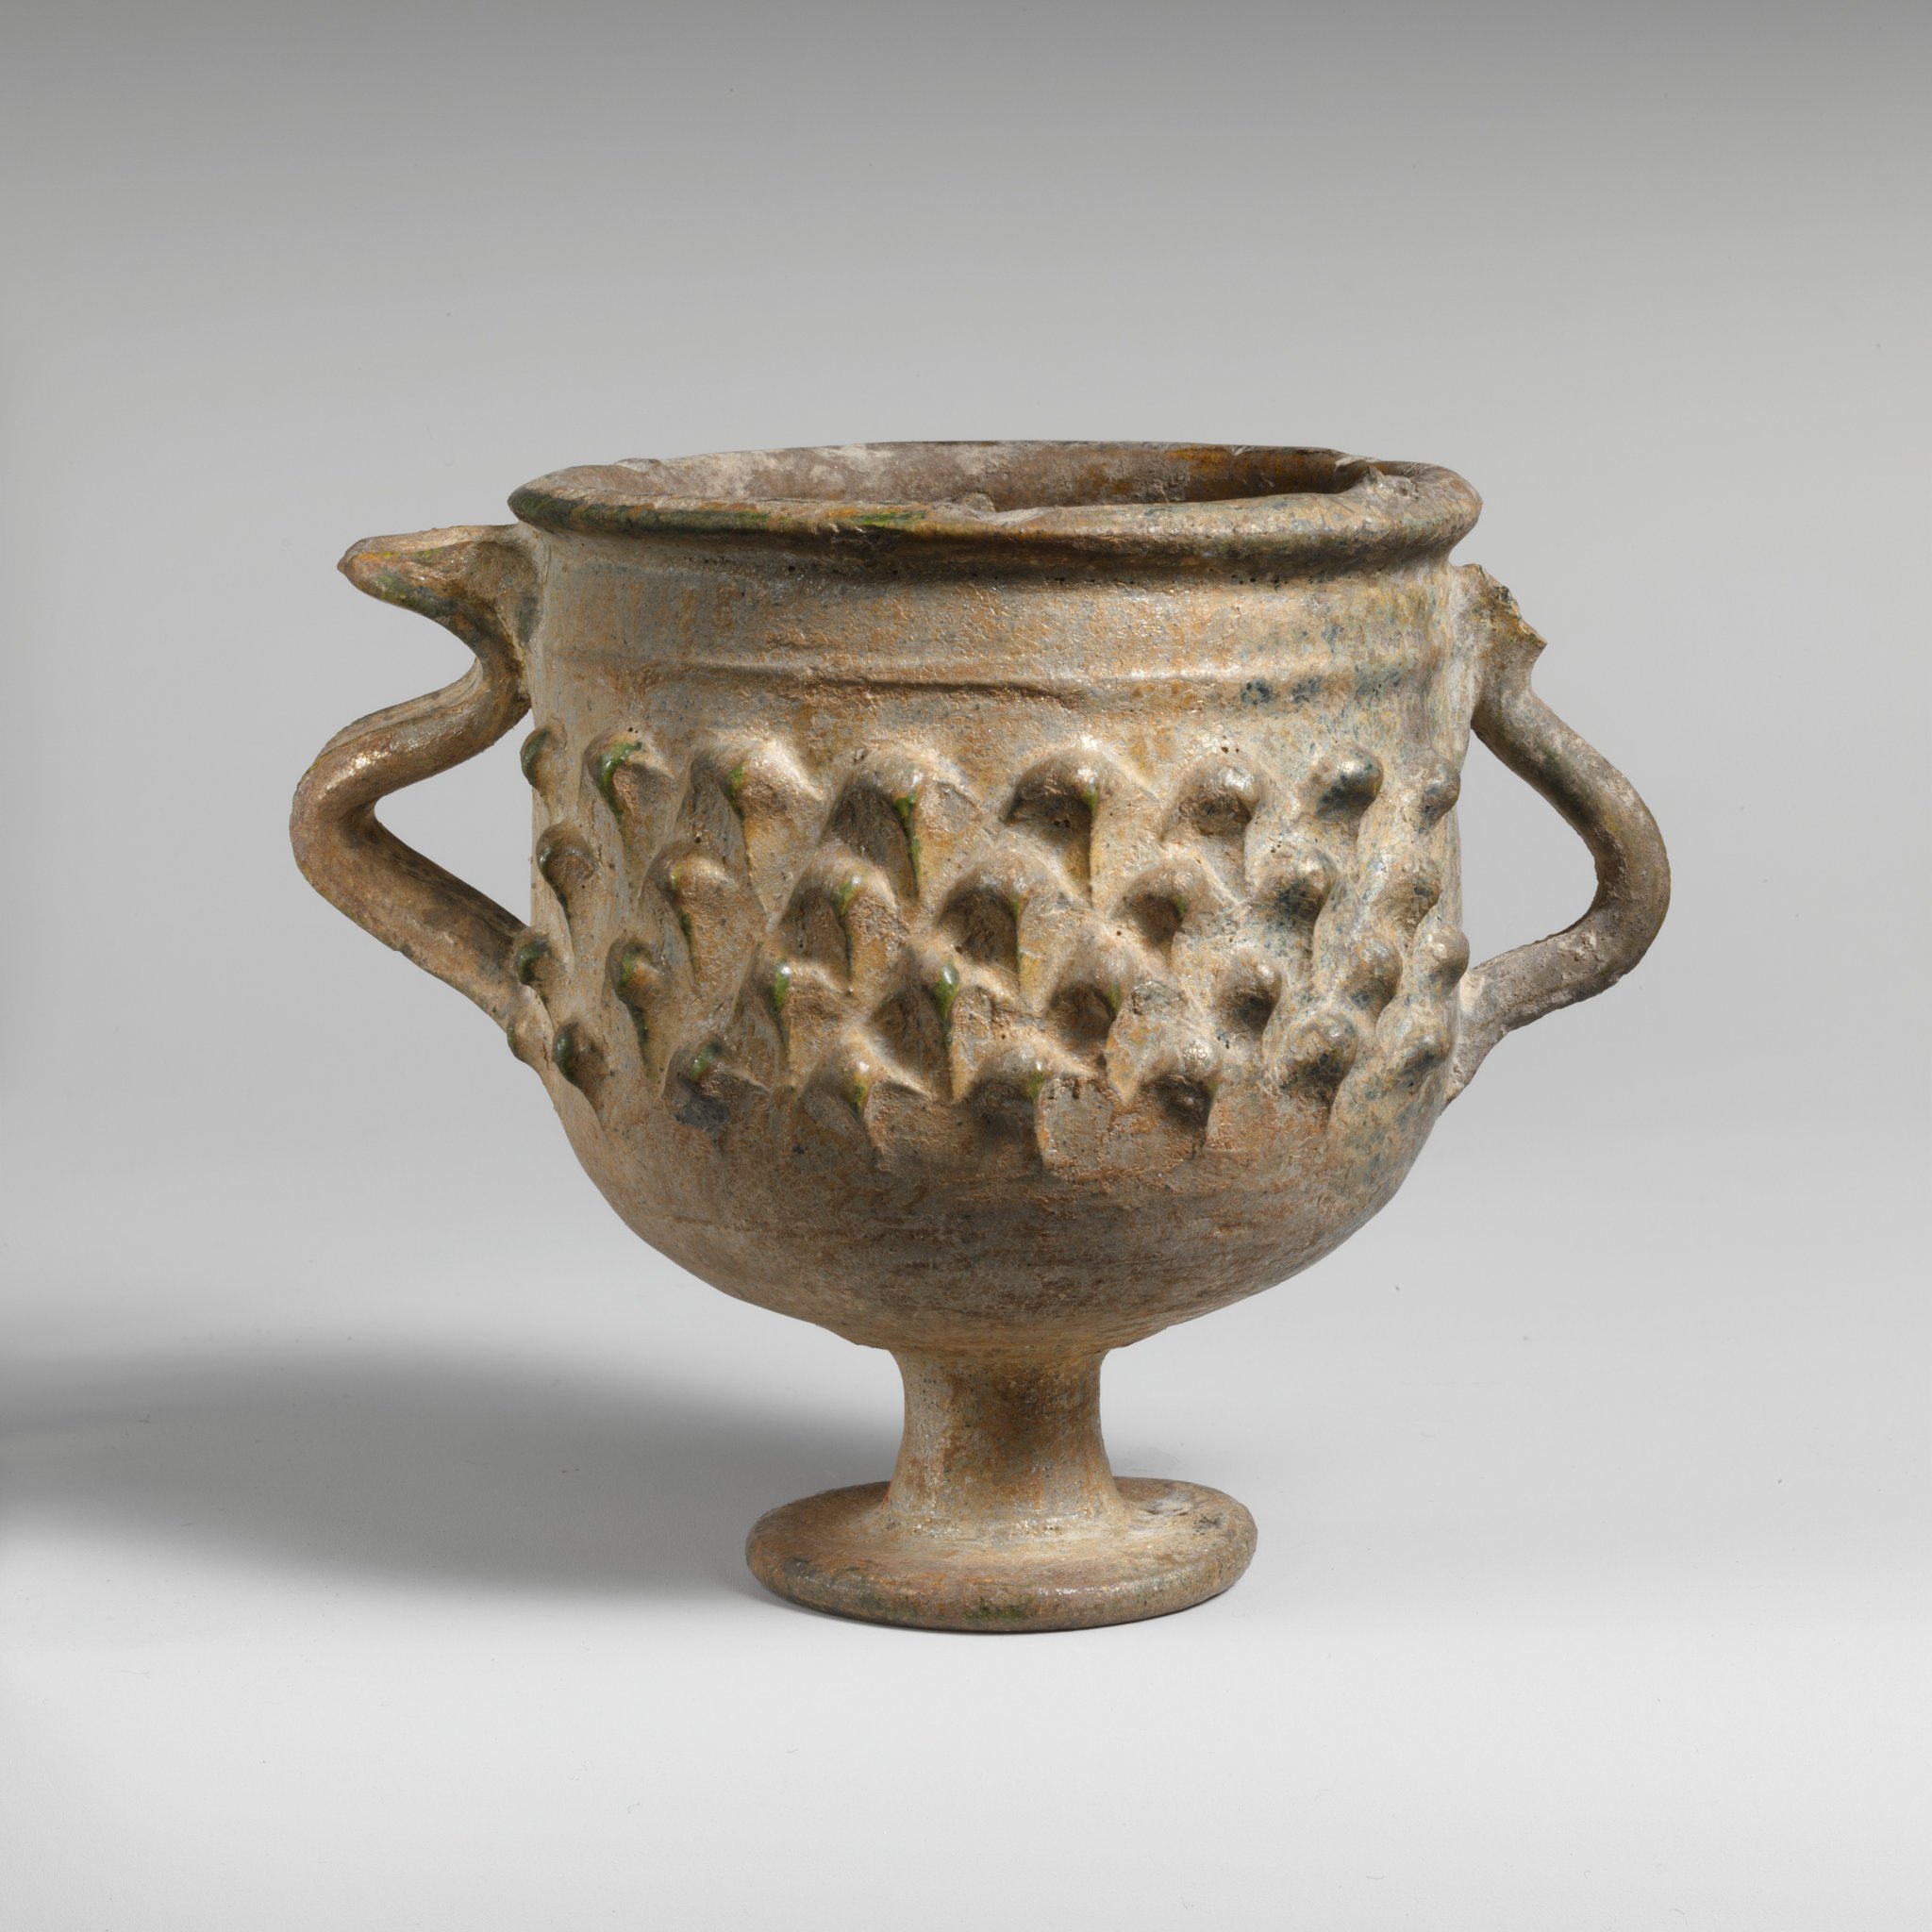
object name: cup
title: Lead-glazed stemmed cup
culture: roman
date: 201-300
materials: terracotta